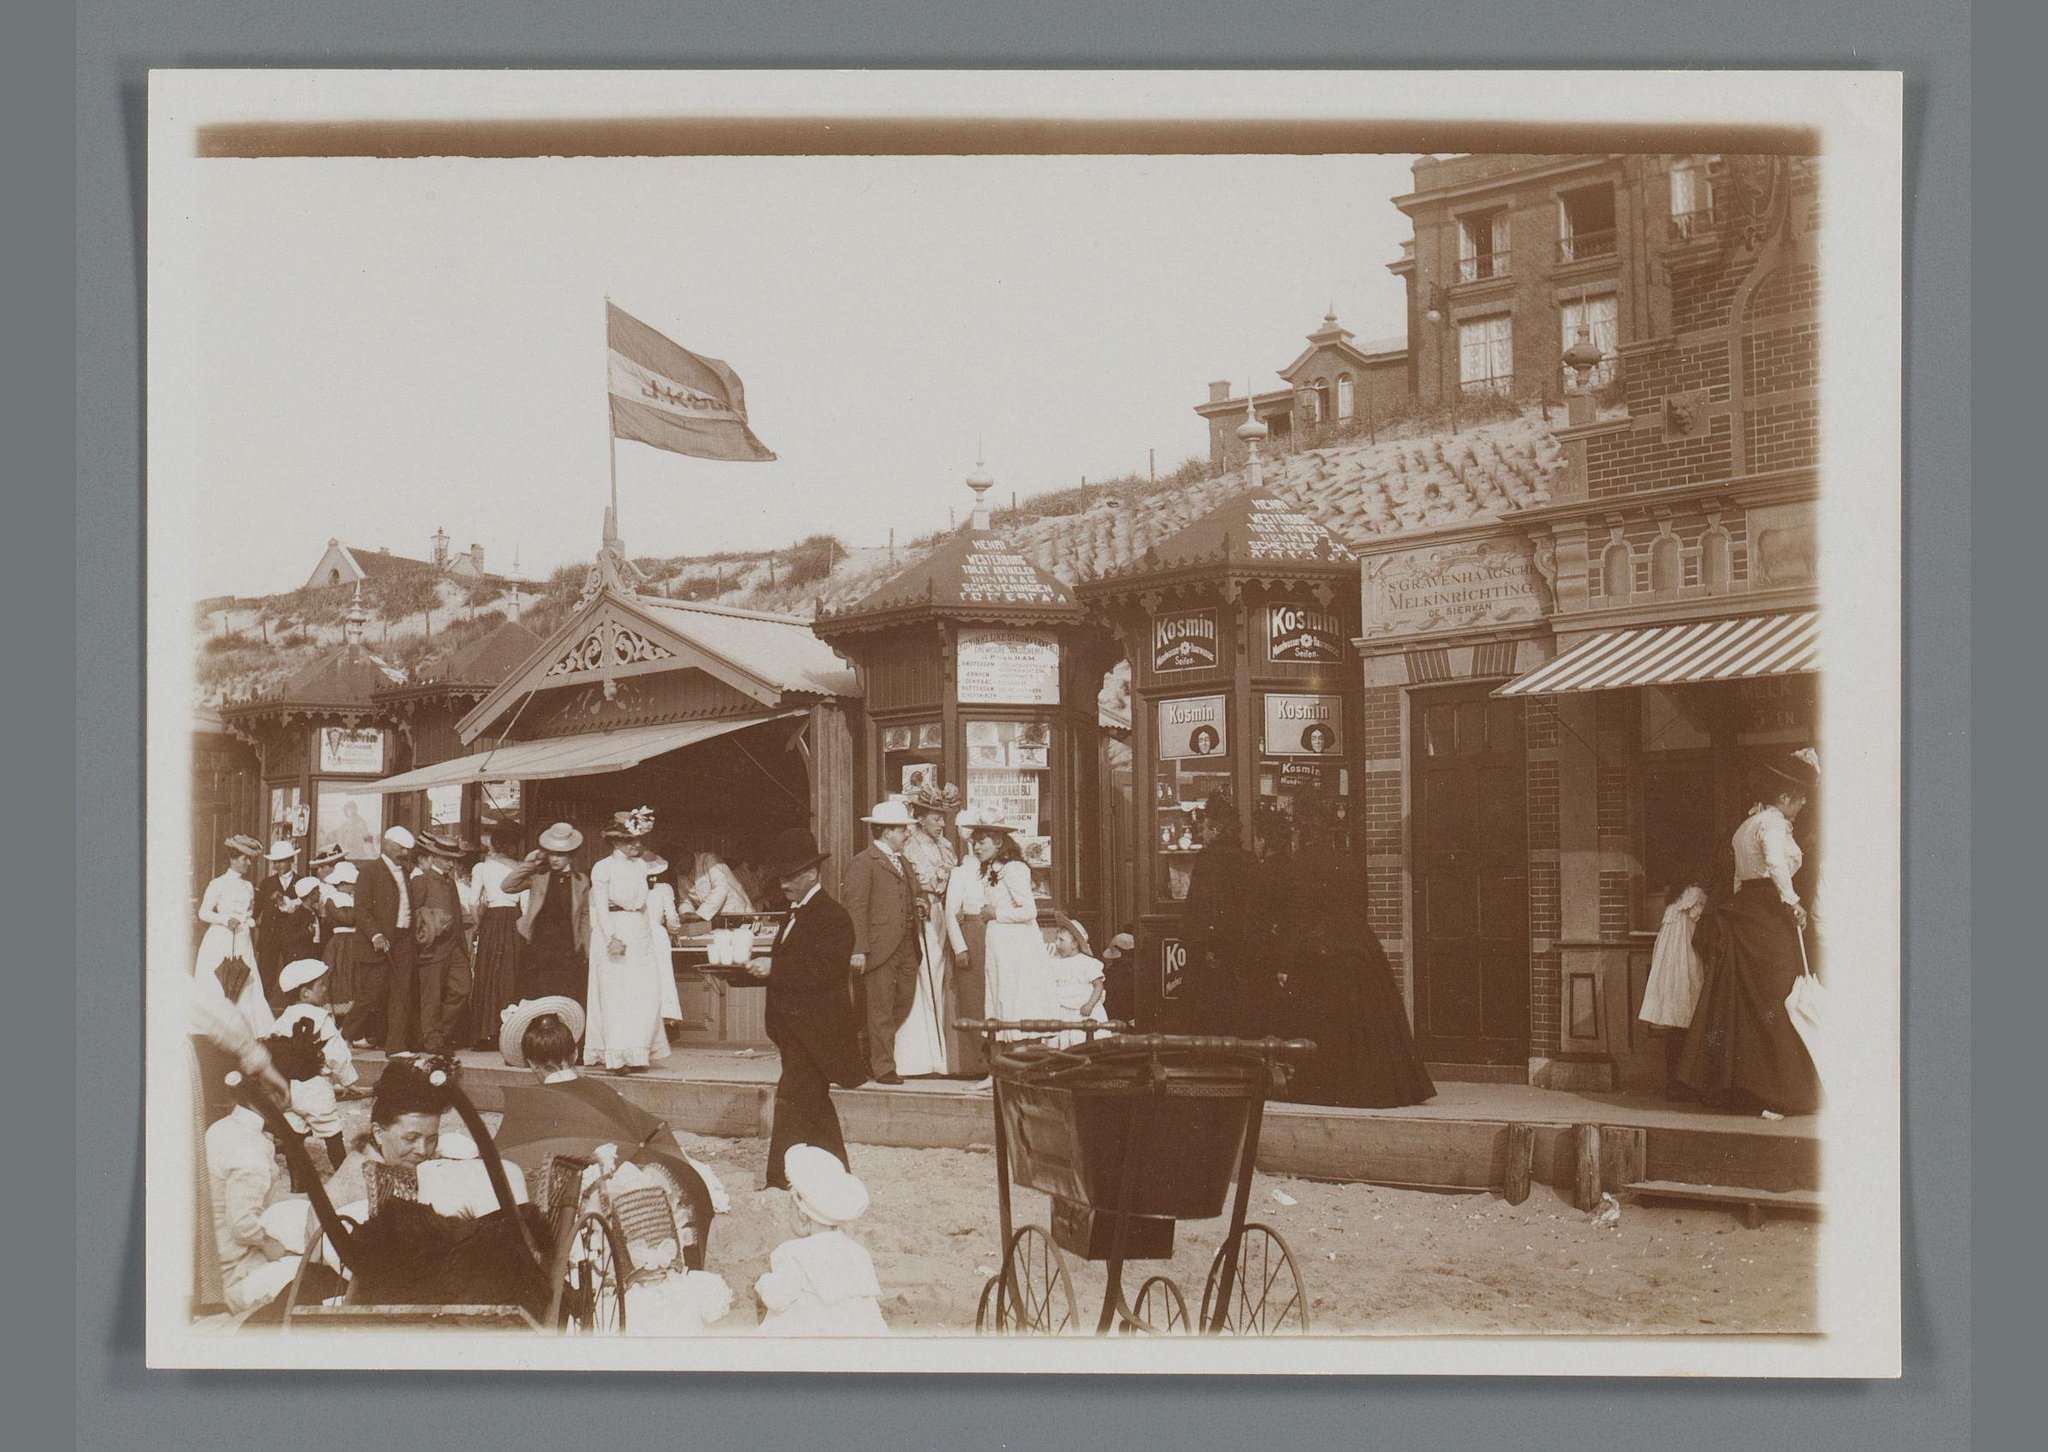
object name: photograph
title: At the Beach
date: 1895-1920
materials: paper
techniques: collodion silver print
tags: open-air recreation, beach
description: Taking photographs and recreation: these two pastimes just begged to be combined. A day at the beach was the perfect opportunity to pull out the camera and capture the experiences with friends and family for posterity. It was almost a cliché. Amateurs could find examples of beach photographs in manuals and magazines and learned, for instance, not to take shots with backlighting.